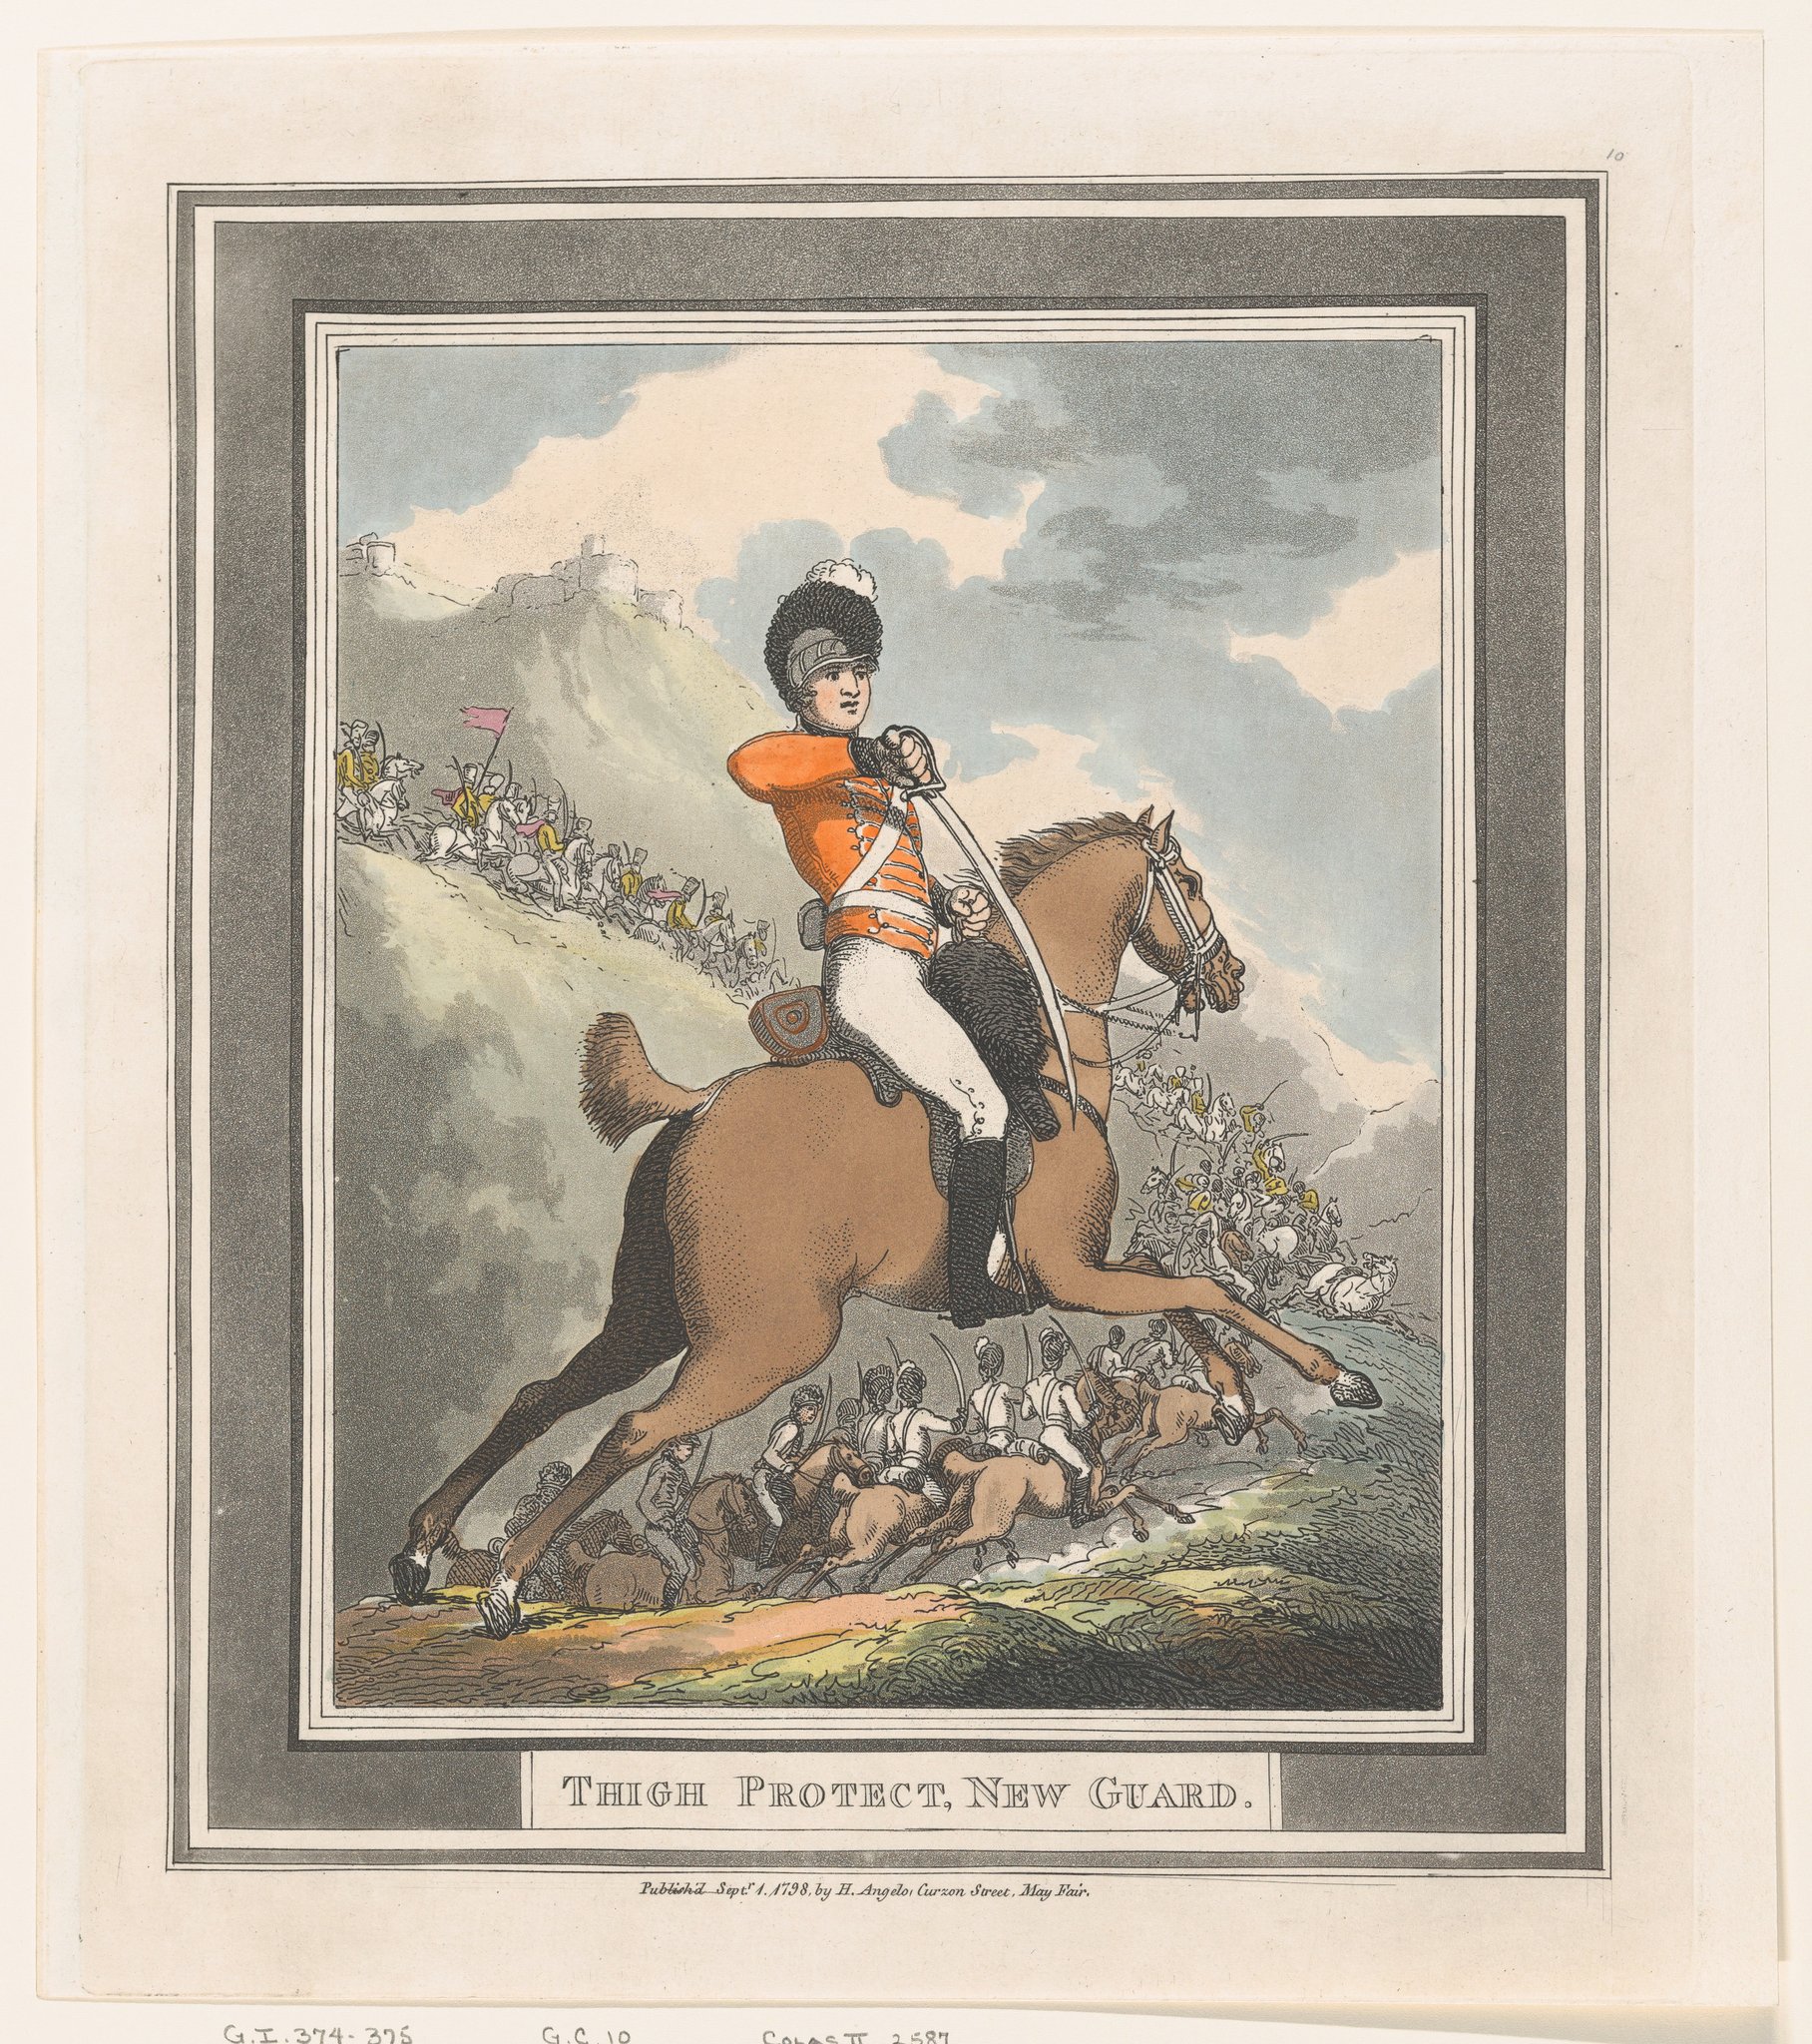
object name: print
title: Thigh Protect, New Guard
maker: thomas rowlandson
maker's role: artist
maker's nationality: british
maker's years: 1757-1827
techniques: aquatint, etching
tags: battles,soldiers,swords,horses